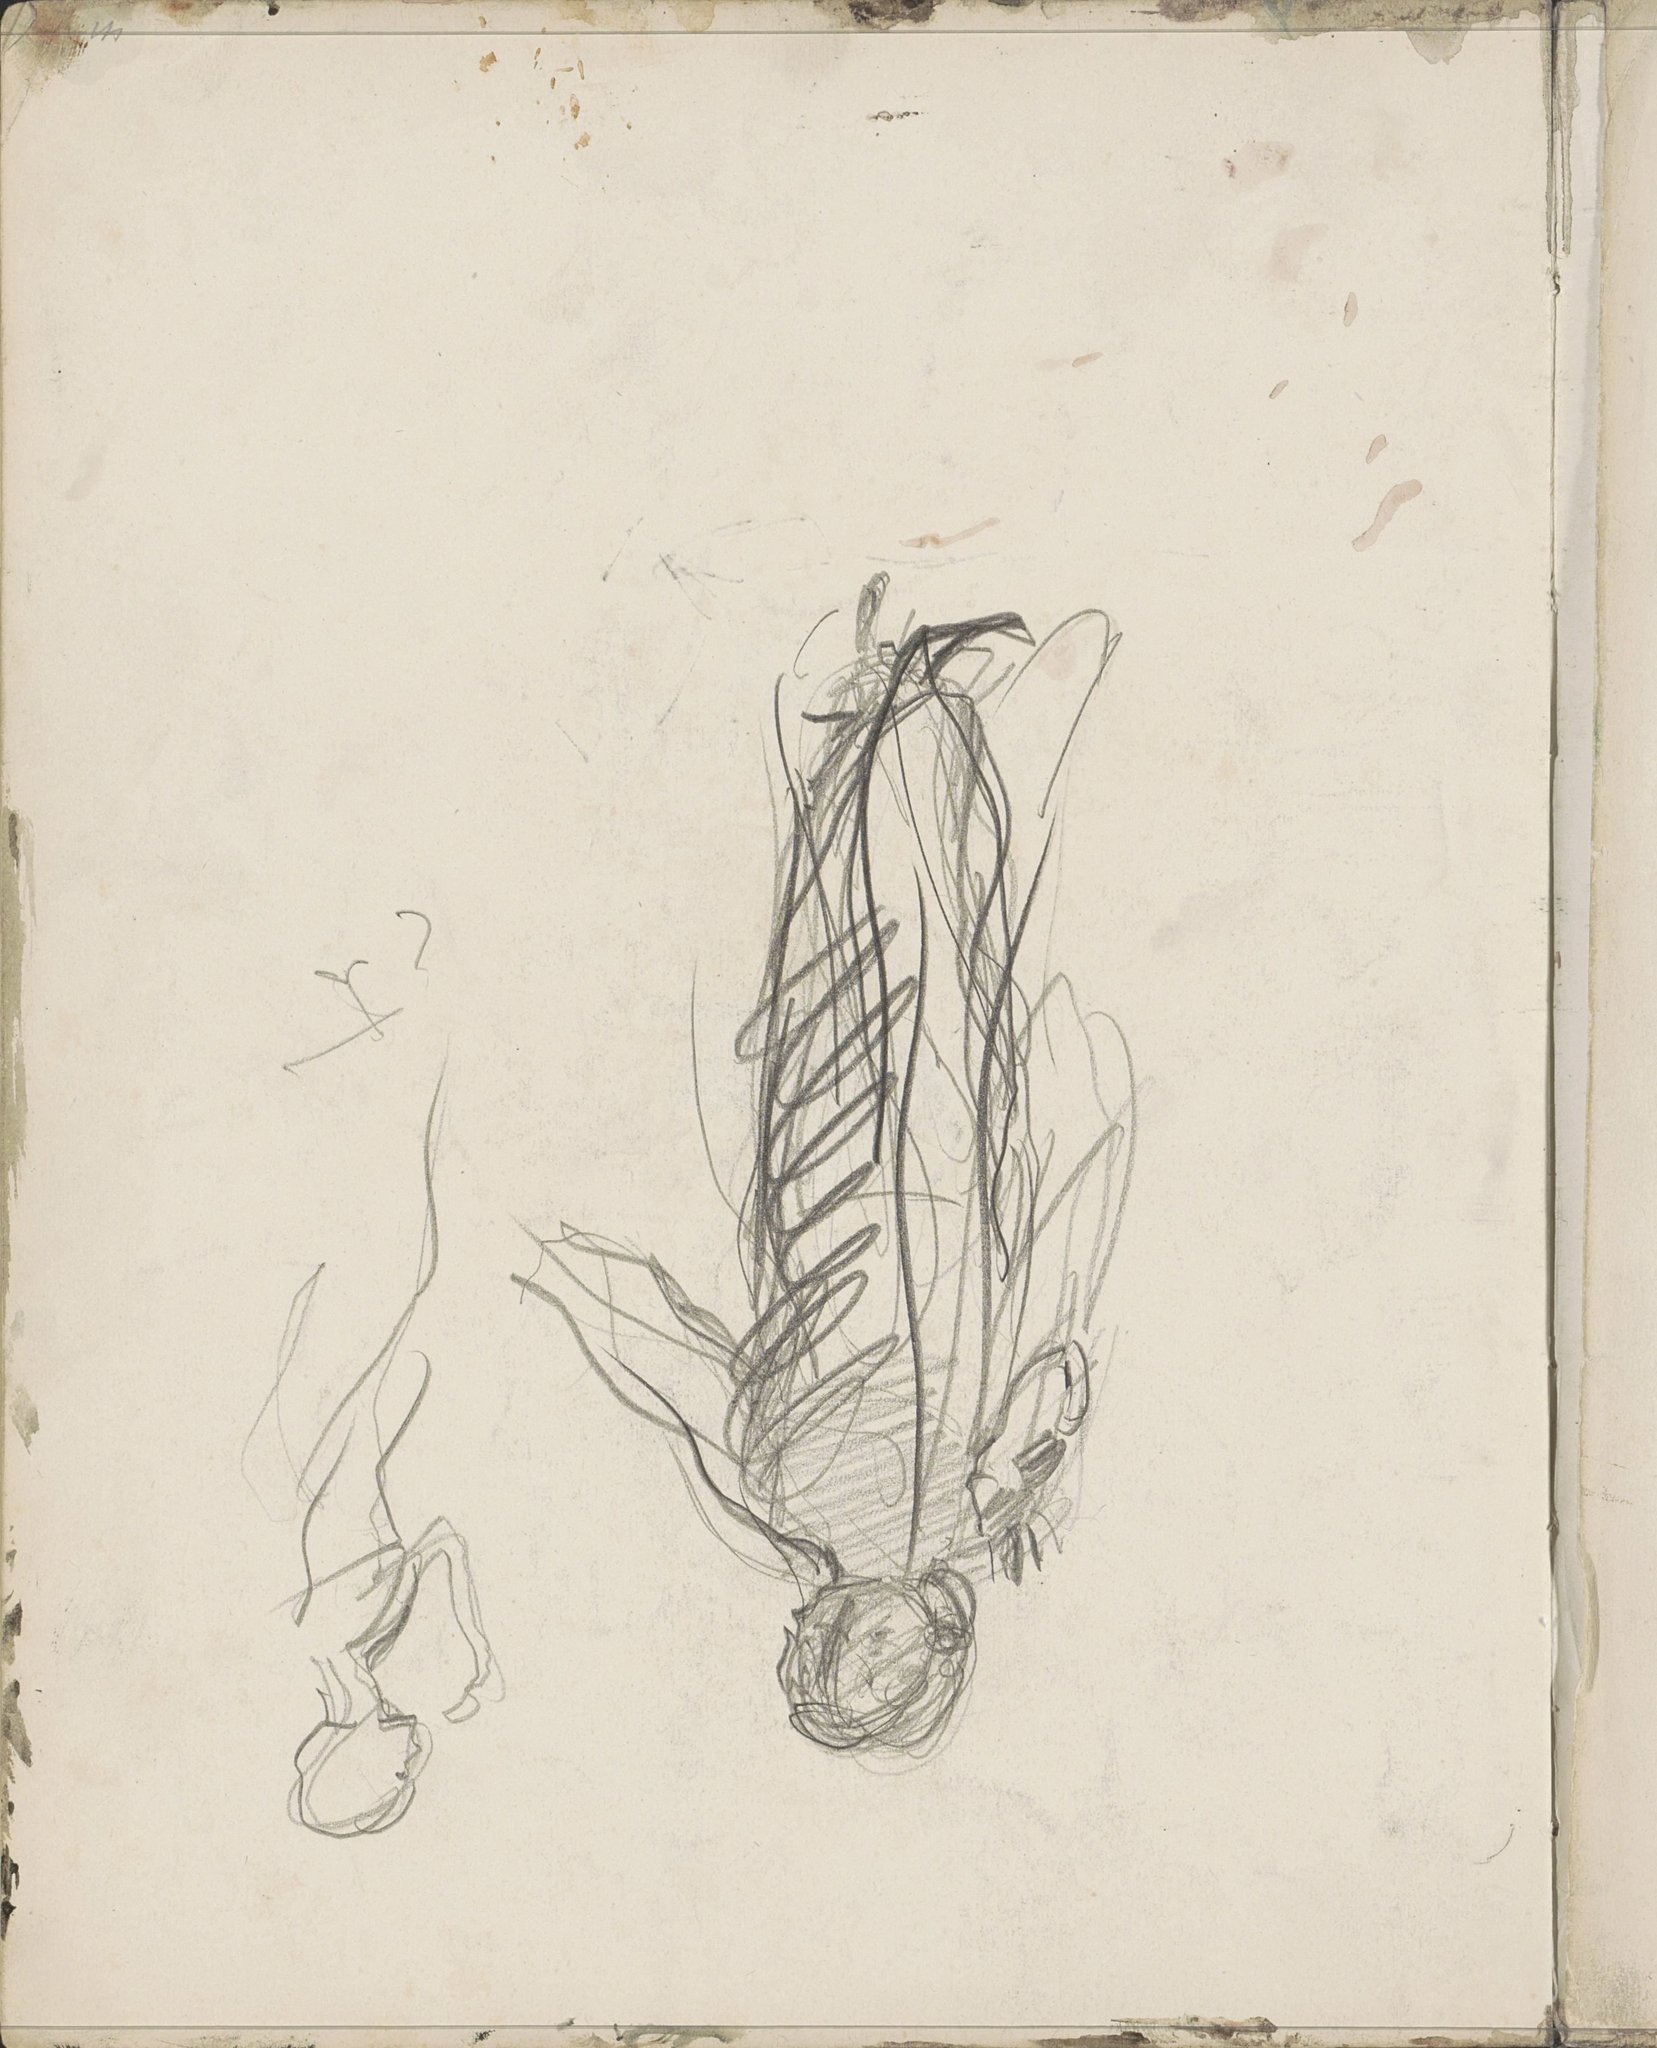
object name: sketchbook leaf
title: Twee staande figuren, mogelijk dansers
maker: isaac israels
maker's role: draughtsman, painter, print maker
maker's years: 1865-1934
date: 1921-1922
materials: paper, pencil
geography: dutch east indies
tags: asiatic races and peoples, standing figure, ballet group; dancers on the stage, dutch east indies, the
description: Blad 4 verso uit schetsboek XIX met 22 bladen.